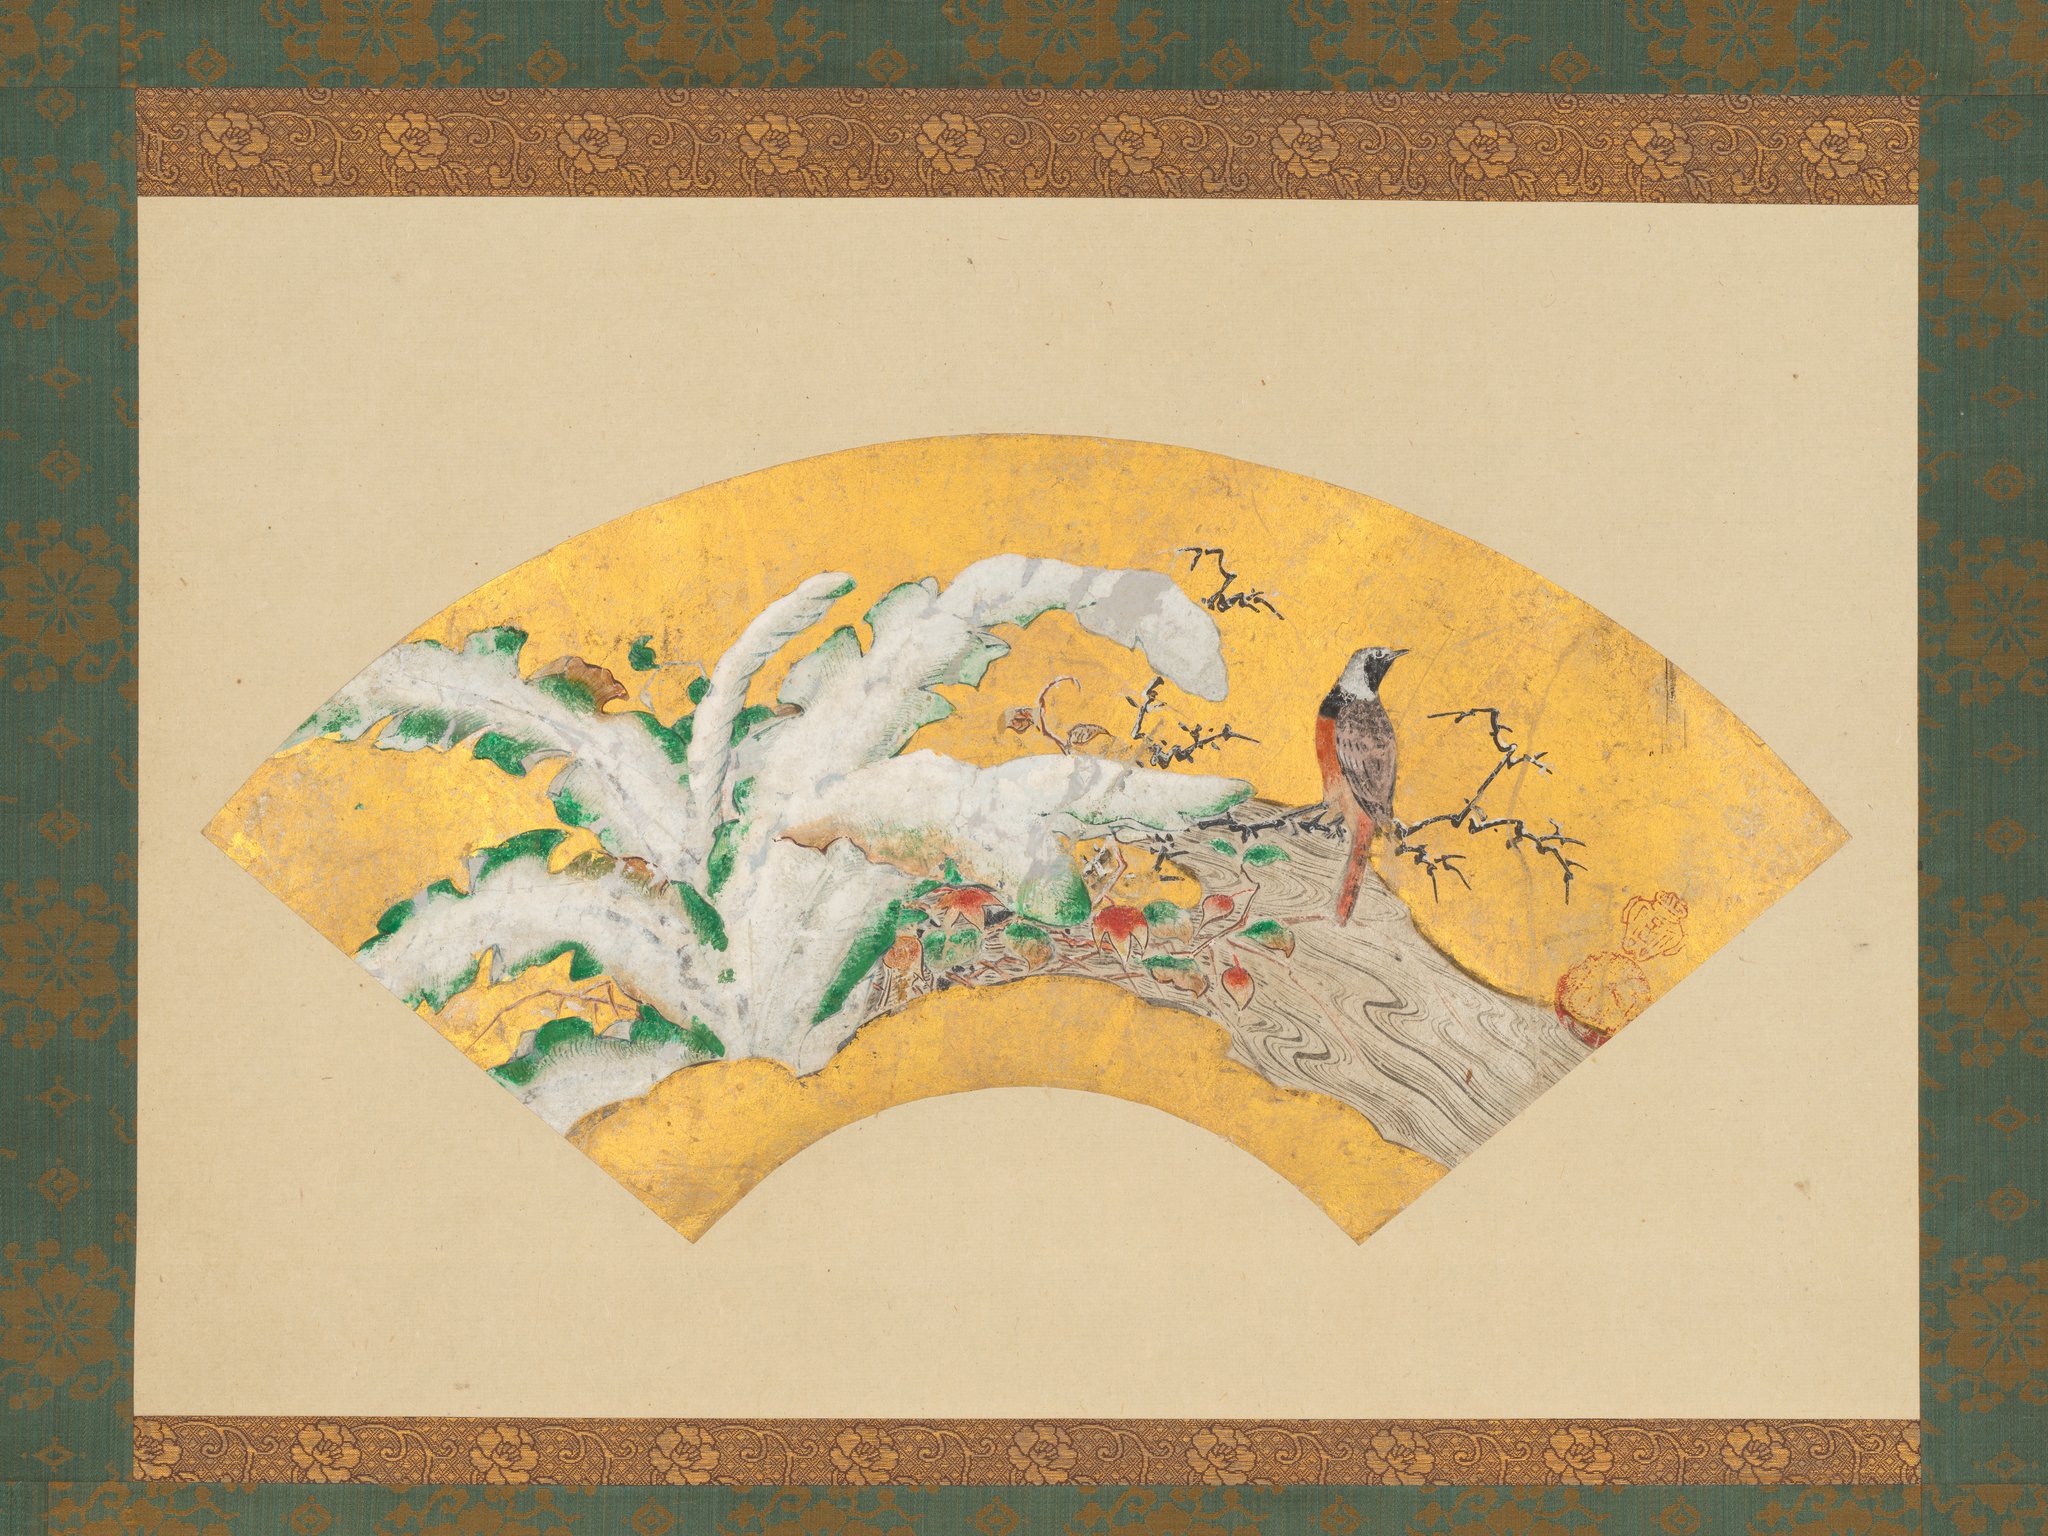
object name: hanging scroll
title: Plantain and Bird in Snow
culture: japanese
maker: kano sōshū 狩野宗秀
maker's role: artist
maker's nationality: japanese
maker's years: 1551-1601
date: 1567-1600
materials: gold leaf, ink, paper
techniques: painting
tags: birds